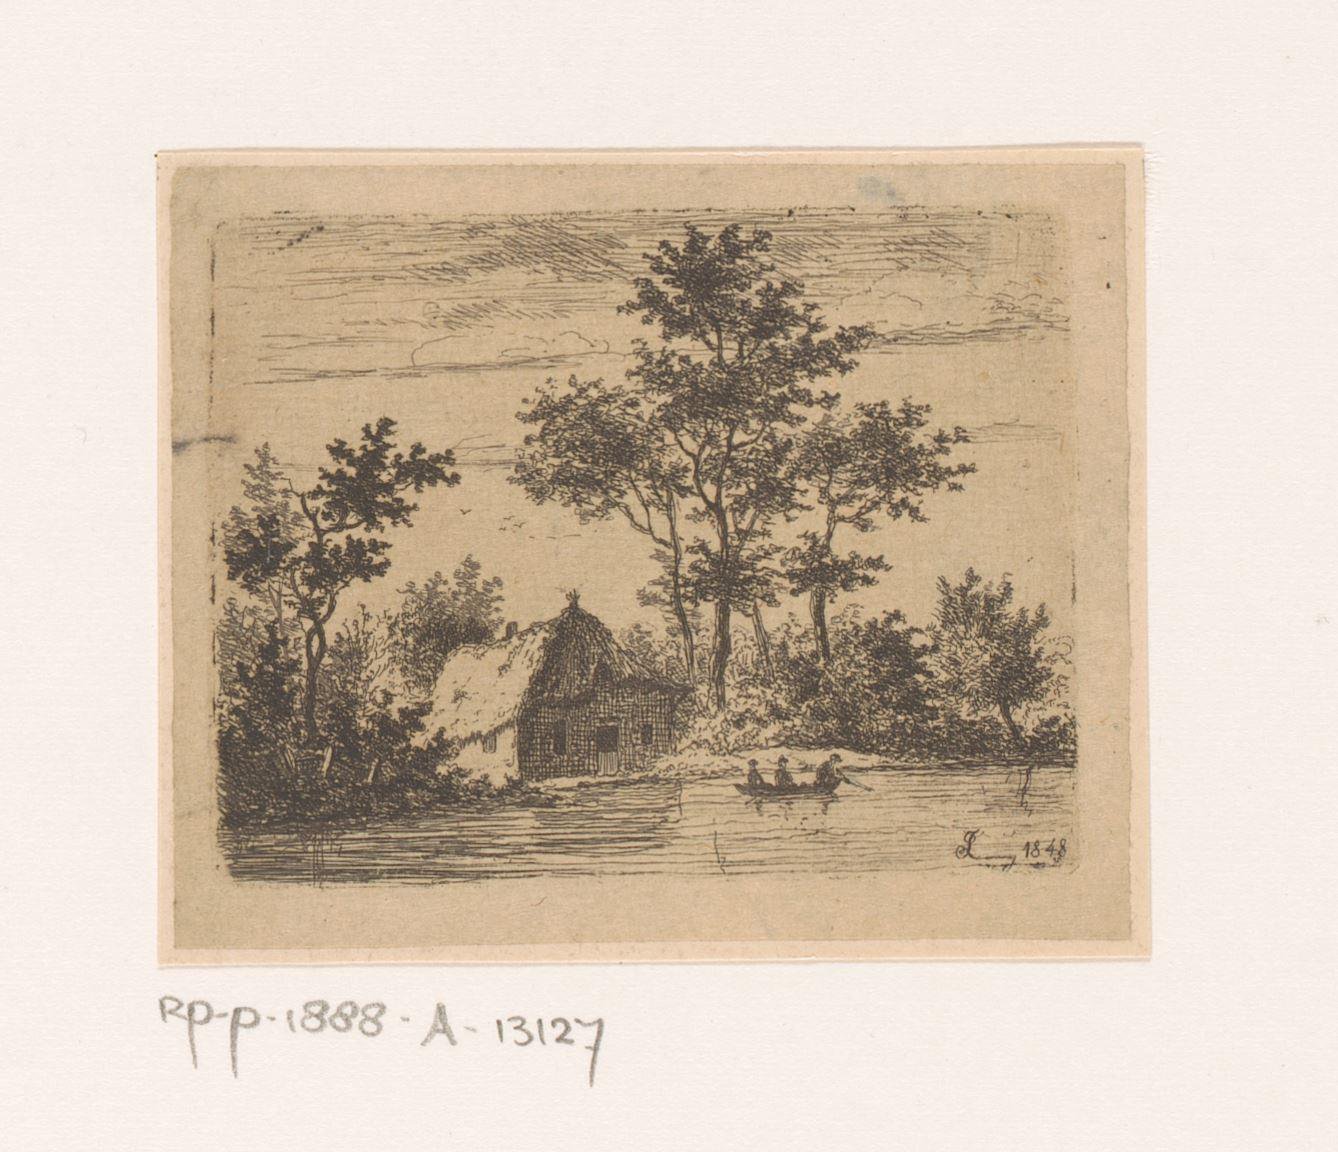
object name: print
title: Landschap bij Pont-à-Celles met een klein gebouw aan het water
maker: jean théodore joseph linnig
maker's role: draughtsman, print maker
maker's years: 1815-1891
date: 1848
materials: paper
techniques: etching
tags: river, rowing-boat, canoe, etc., hut, cabin, lodge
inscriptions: collector's mark: Lugt 2228